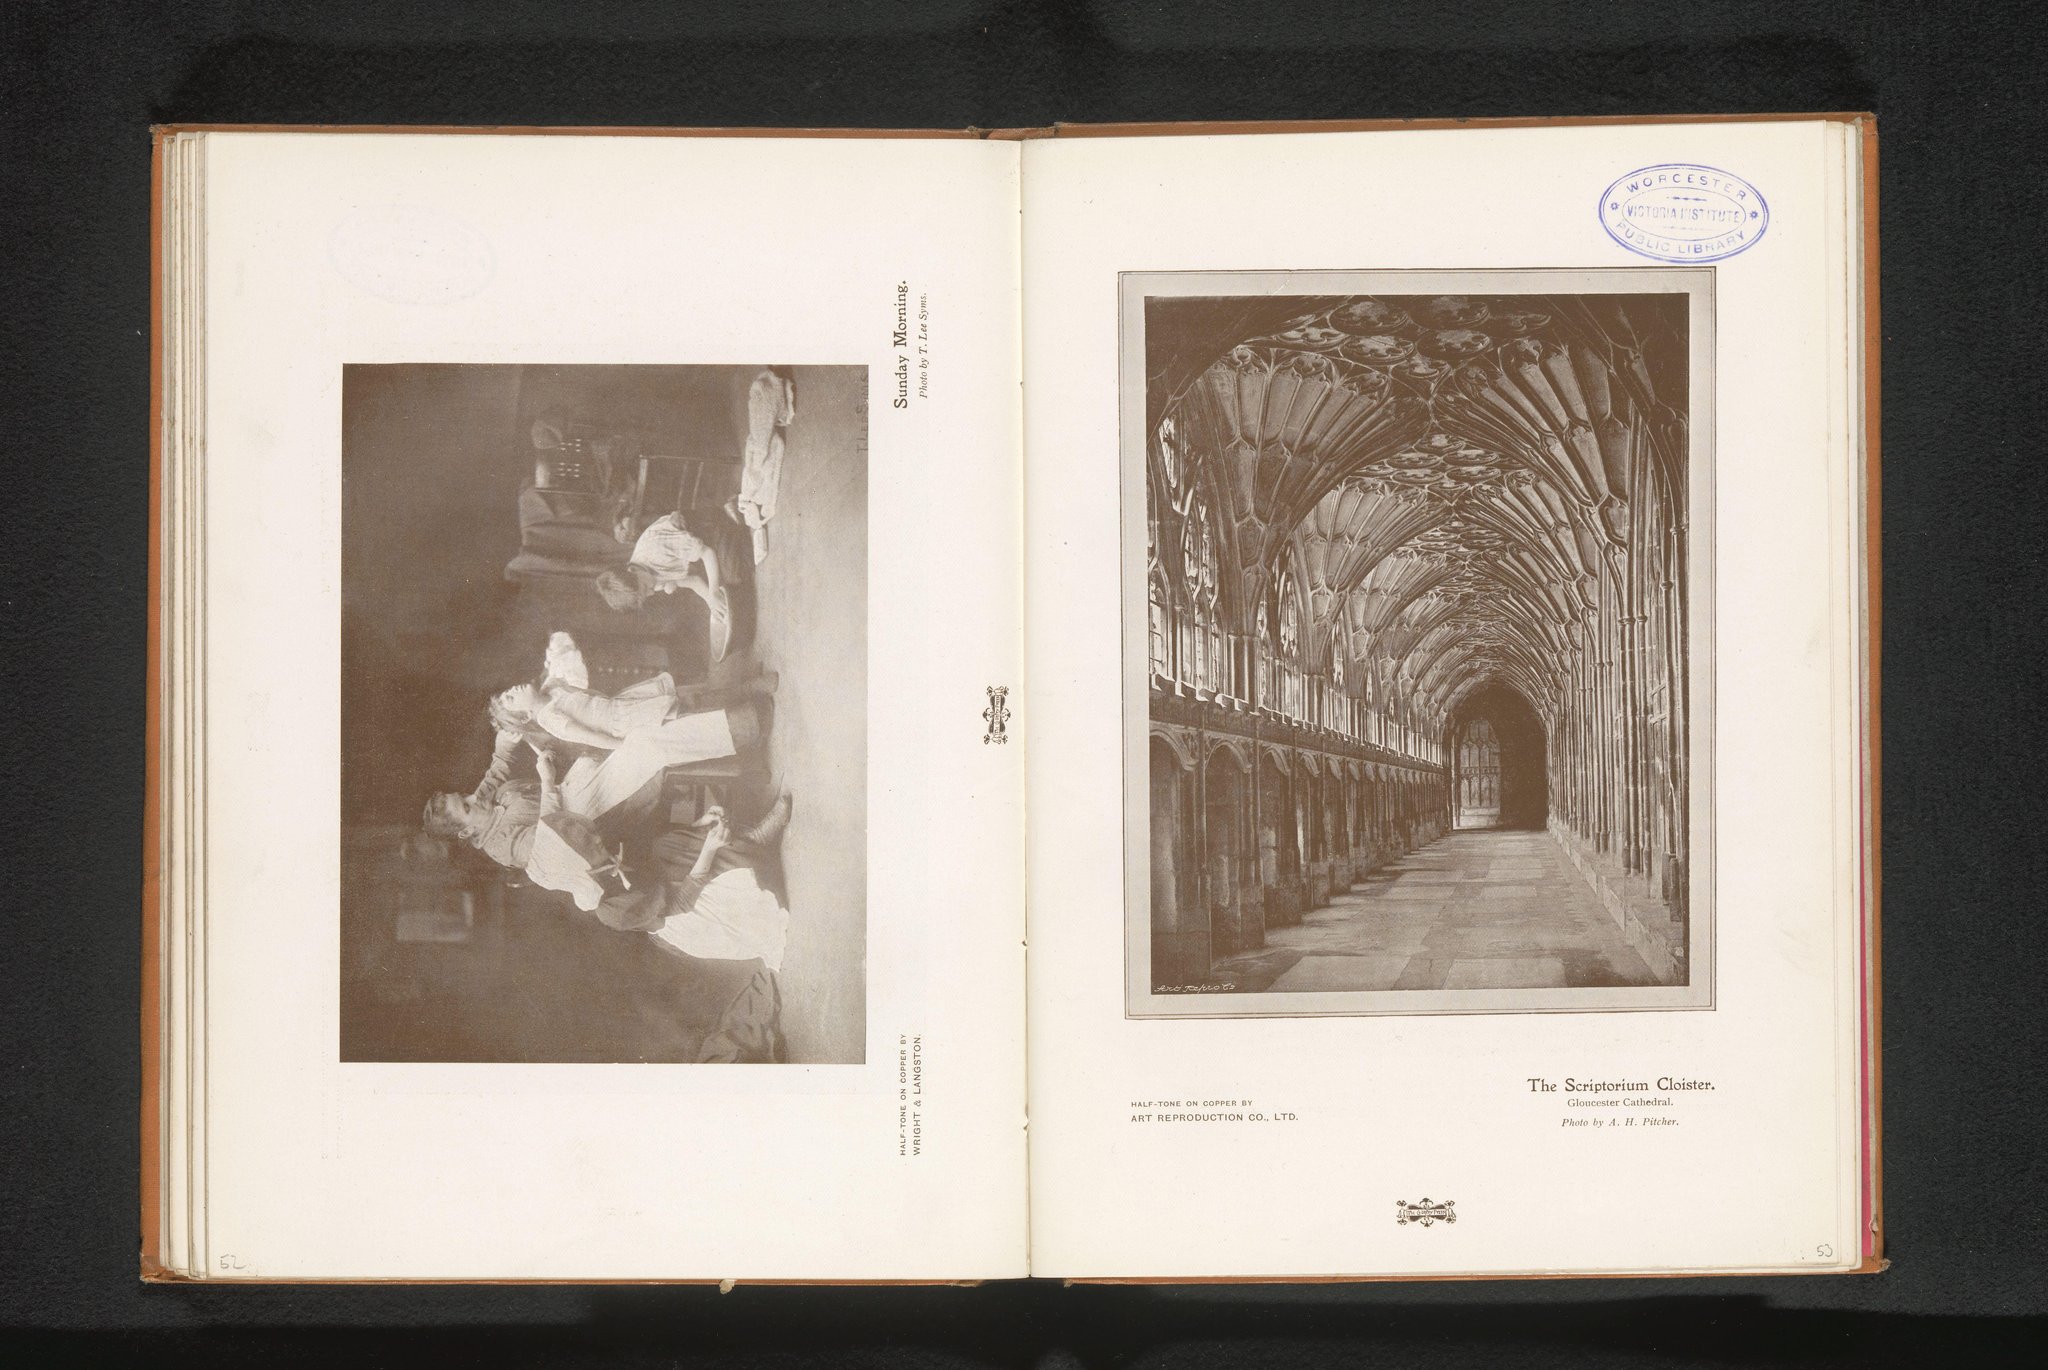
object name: photomechanical print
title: The Scriptorium Cloister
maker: arthur h. pitcher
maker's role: fotograaf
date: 1894-1899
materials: paper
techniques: autotype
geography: gloucester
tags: cloisters ~ monastery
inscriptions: collector's mark: ‘Worcester Public Library/ Victoria Institute’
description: Prent op vijfde ongenummerde pagina na pagina 72.